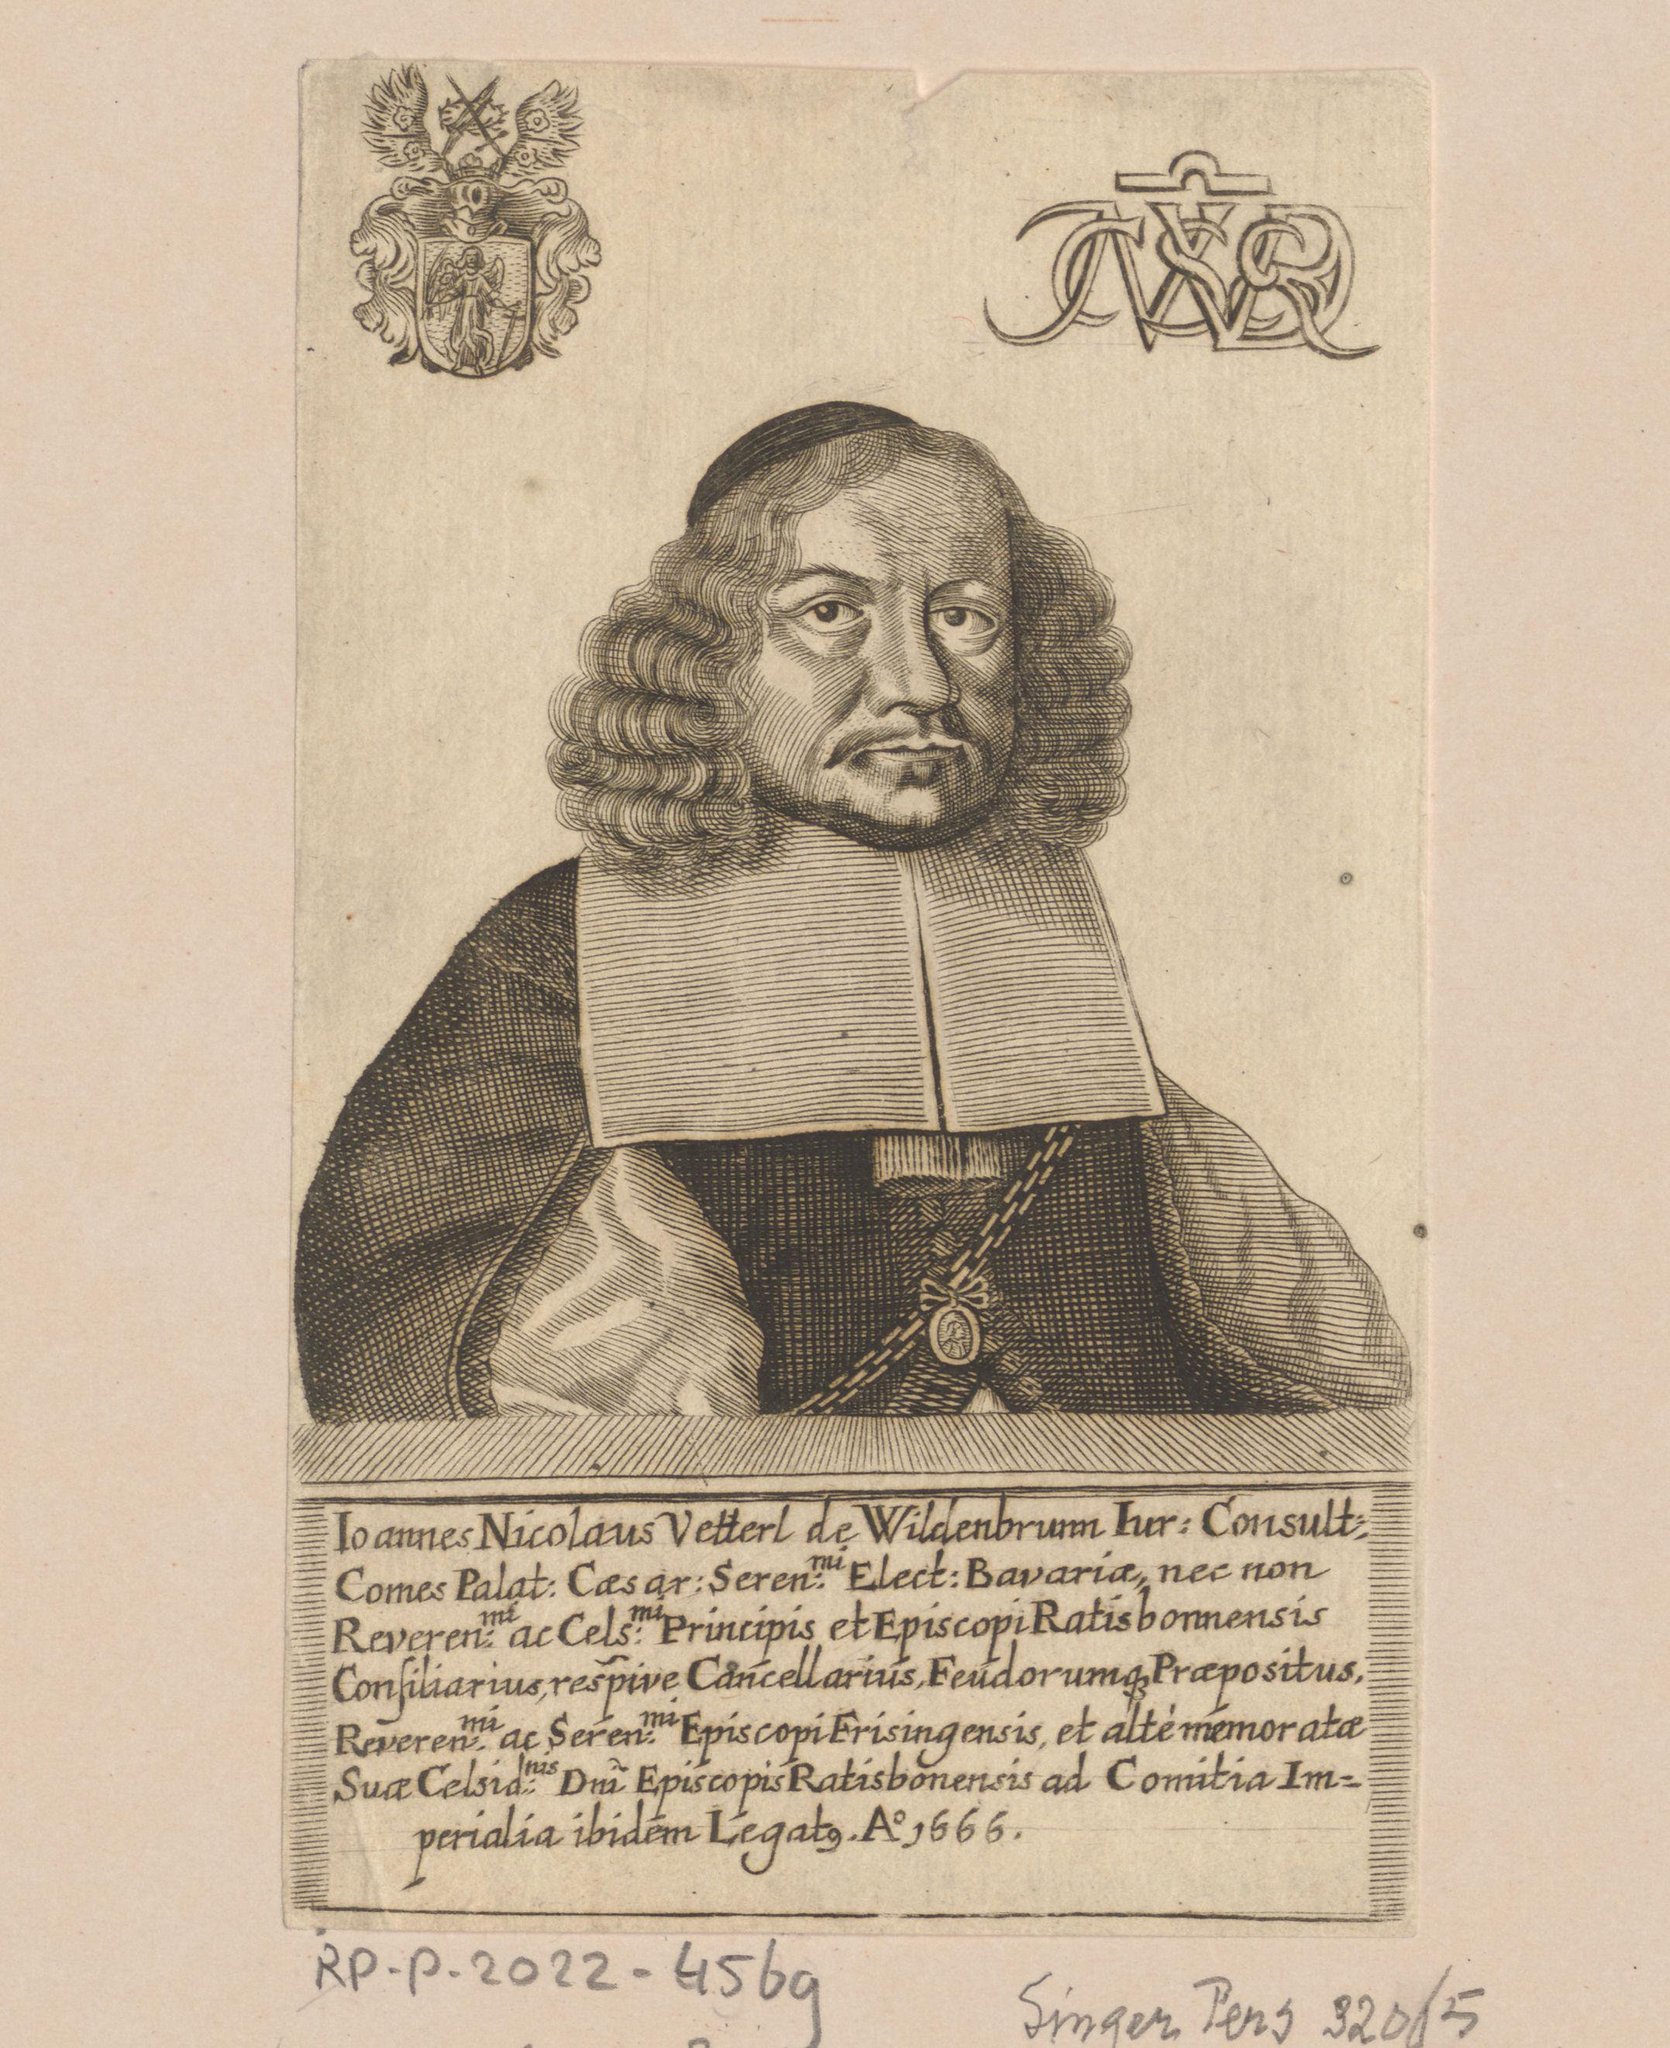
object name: print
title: Portret van Johann Nikolaus Vetterl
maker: Anonymous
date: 1666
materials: paper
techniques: engraving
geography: germany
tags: official; civil servant; functionary (in general), historical persons, lawyer, attorney at law, armorial bearing, heraldry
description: Met zevenregelig onderschrift in het Latijn.